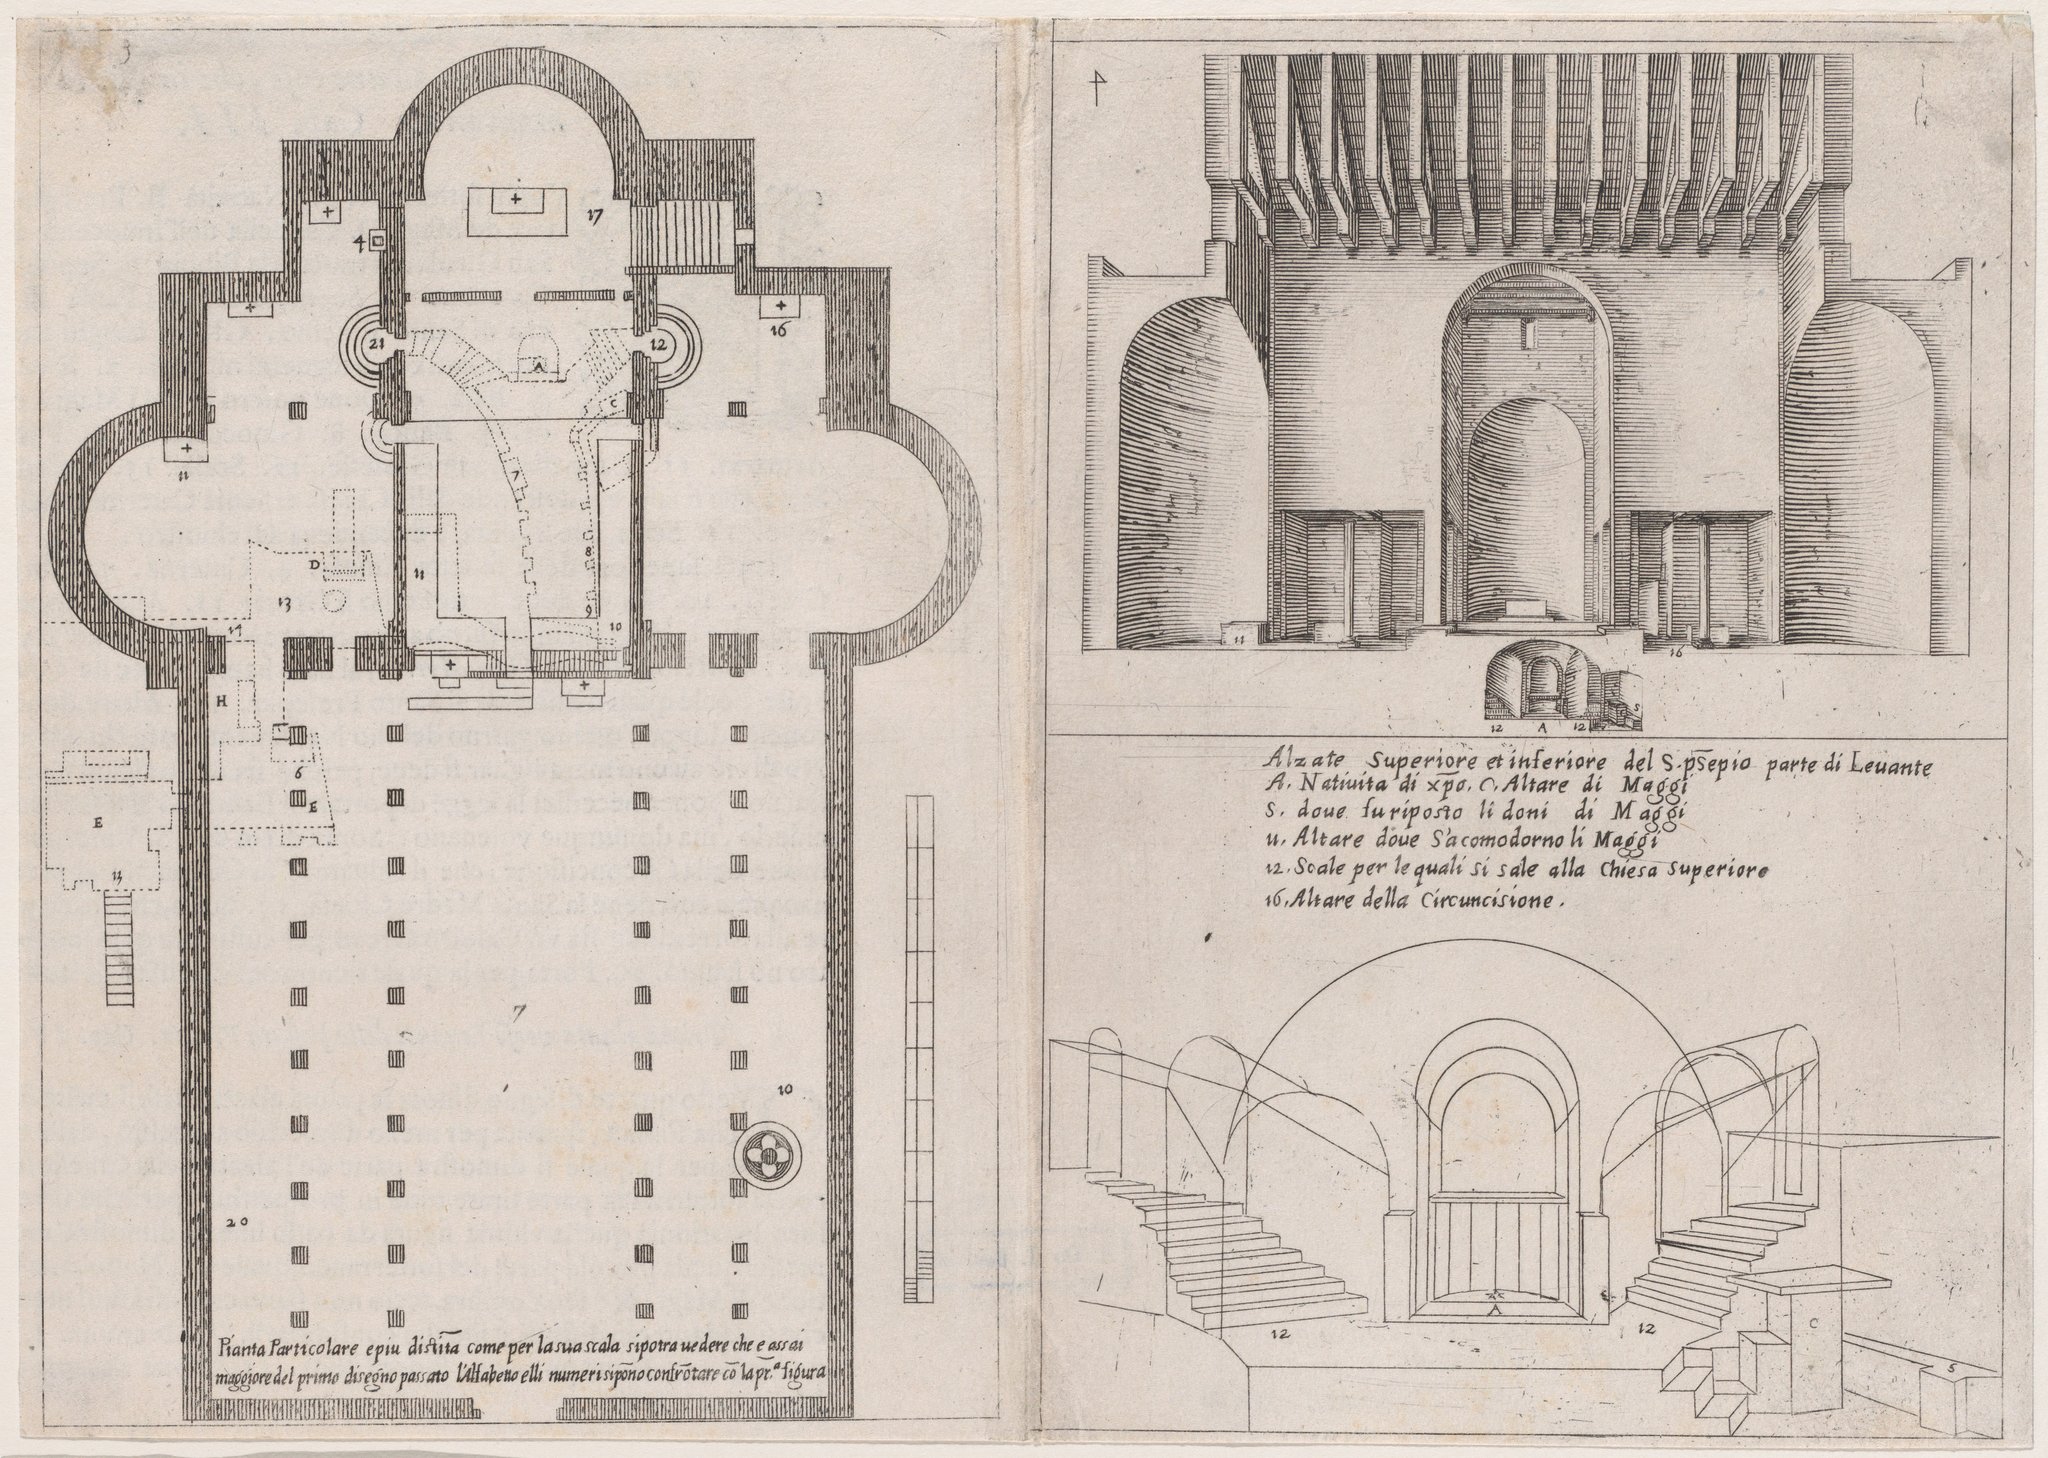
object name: print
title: Plates 3 and 4, from "Trattato delle Piante & Immagini de Sacri Edifizi di Terra Santa" (Treatise of the Plans & Images of the Sacred Buildings of the Holy Land)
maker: jacques callot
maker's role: artist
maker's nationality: french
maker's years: 1592-1635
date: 1620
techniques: engraving, etching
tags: architecture,buildings